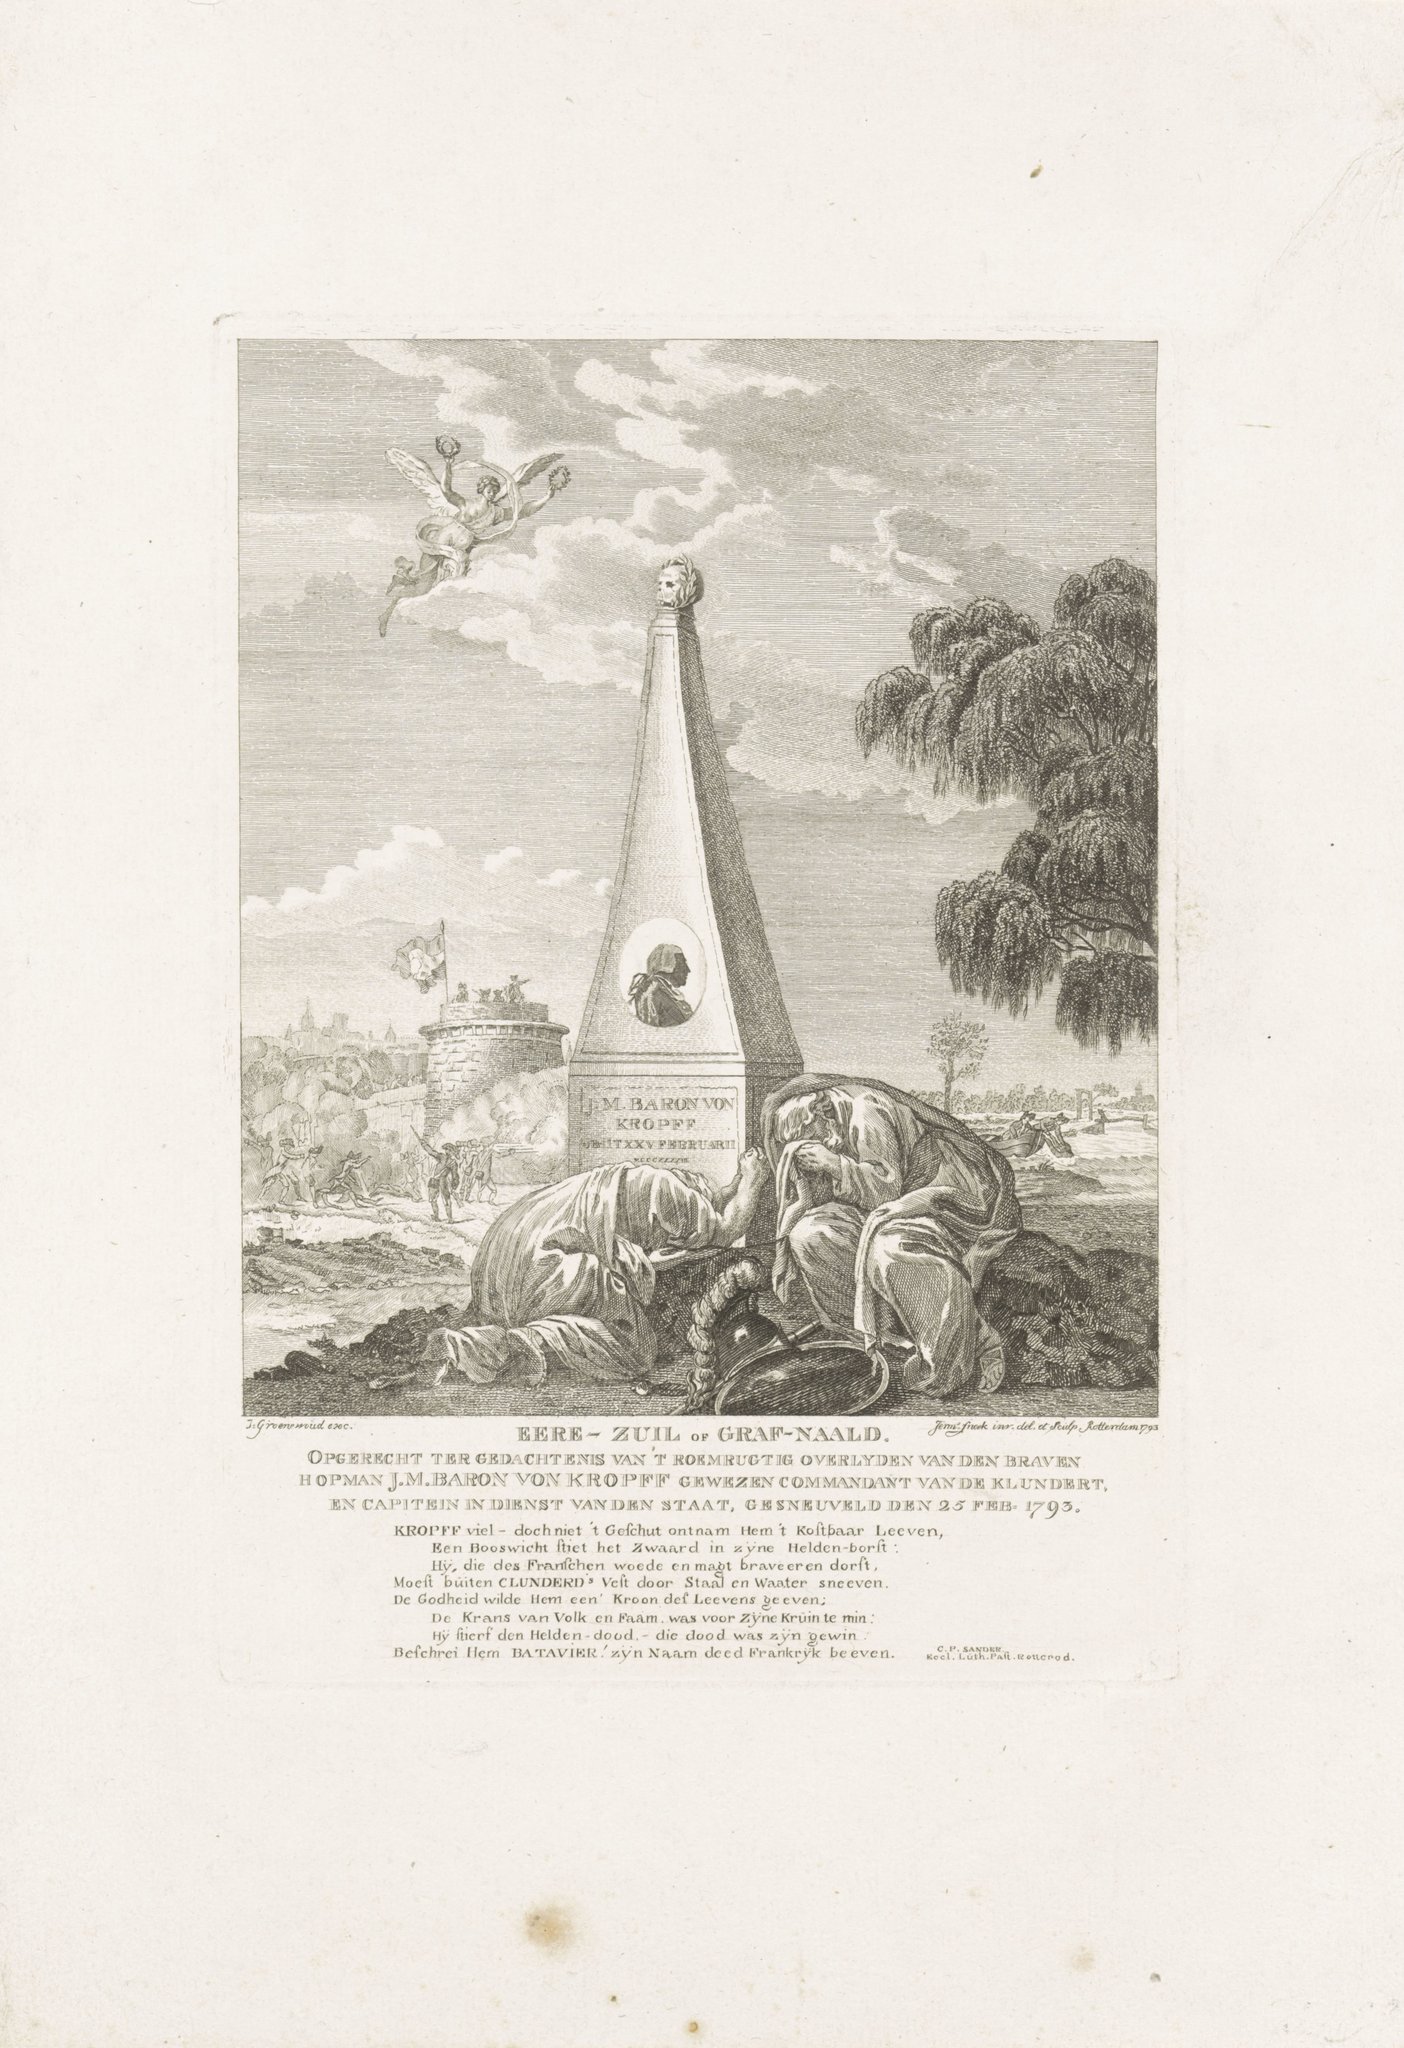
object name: print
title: Eere-Zuil of Graf-Naald. Opgerecht ter gedachtenis van (...) J.M. Baron von Kropff (...)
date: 1793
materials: paper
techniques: engraving, etching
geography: rotterdam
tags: klundert, grave-building, monumental tomb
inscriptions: collector's mark: Lugt 2228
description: Allegorisch monument voor Joachim Maurits baron van Kropff, gesneuveld bij de verdediging van Klundert tegen het Franse leger, 25 februari 1793. Voor een grafnaald twee voorover gebogen treurende figuren, Constitutie en Vaderlandsliefde. In de lucht de Faam met twee kransen. Op met monument een medaillon met portret. Op de achtergrond de verdediging van de vesting en het uit het water halen van zijn lichaam. In het onderschrift een achtregelig vers. Bij de prent behoort een uitleg.